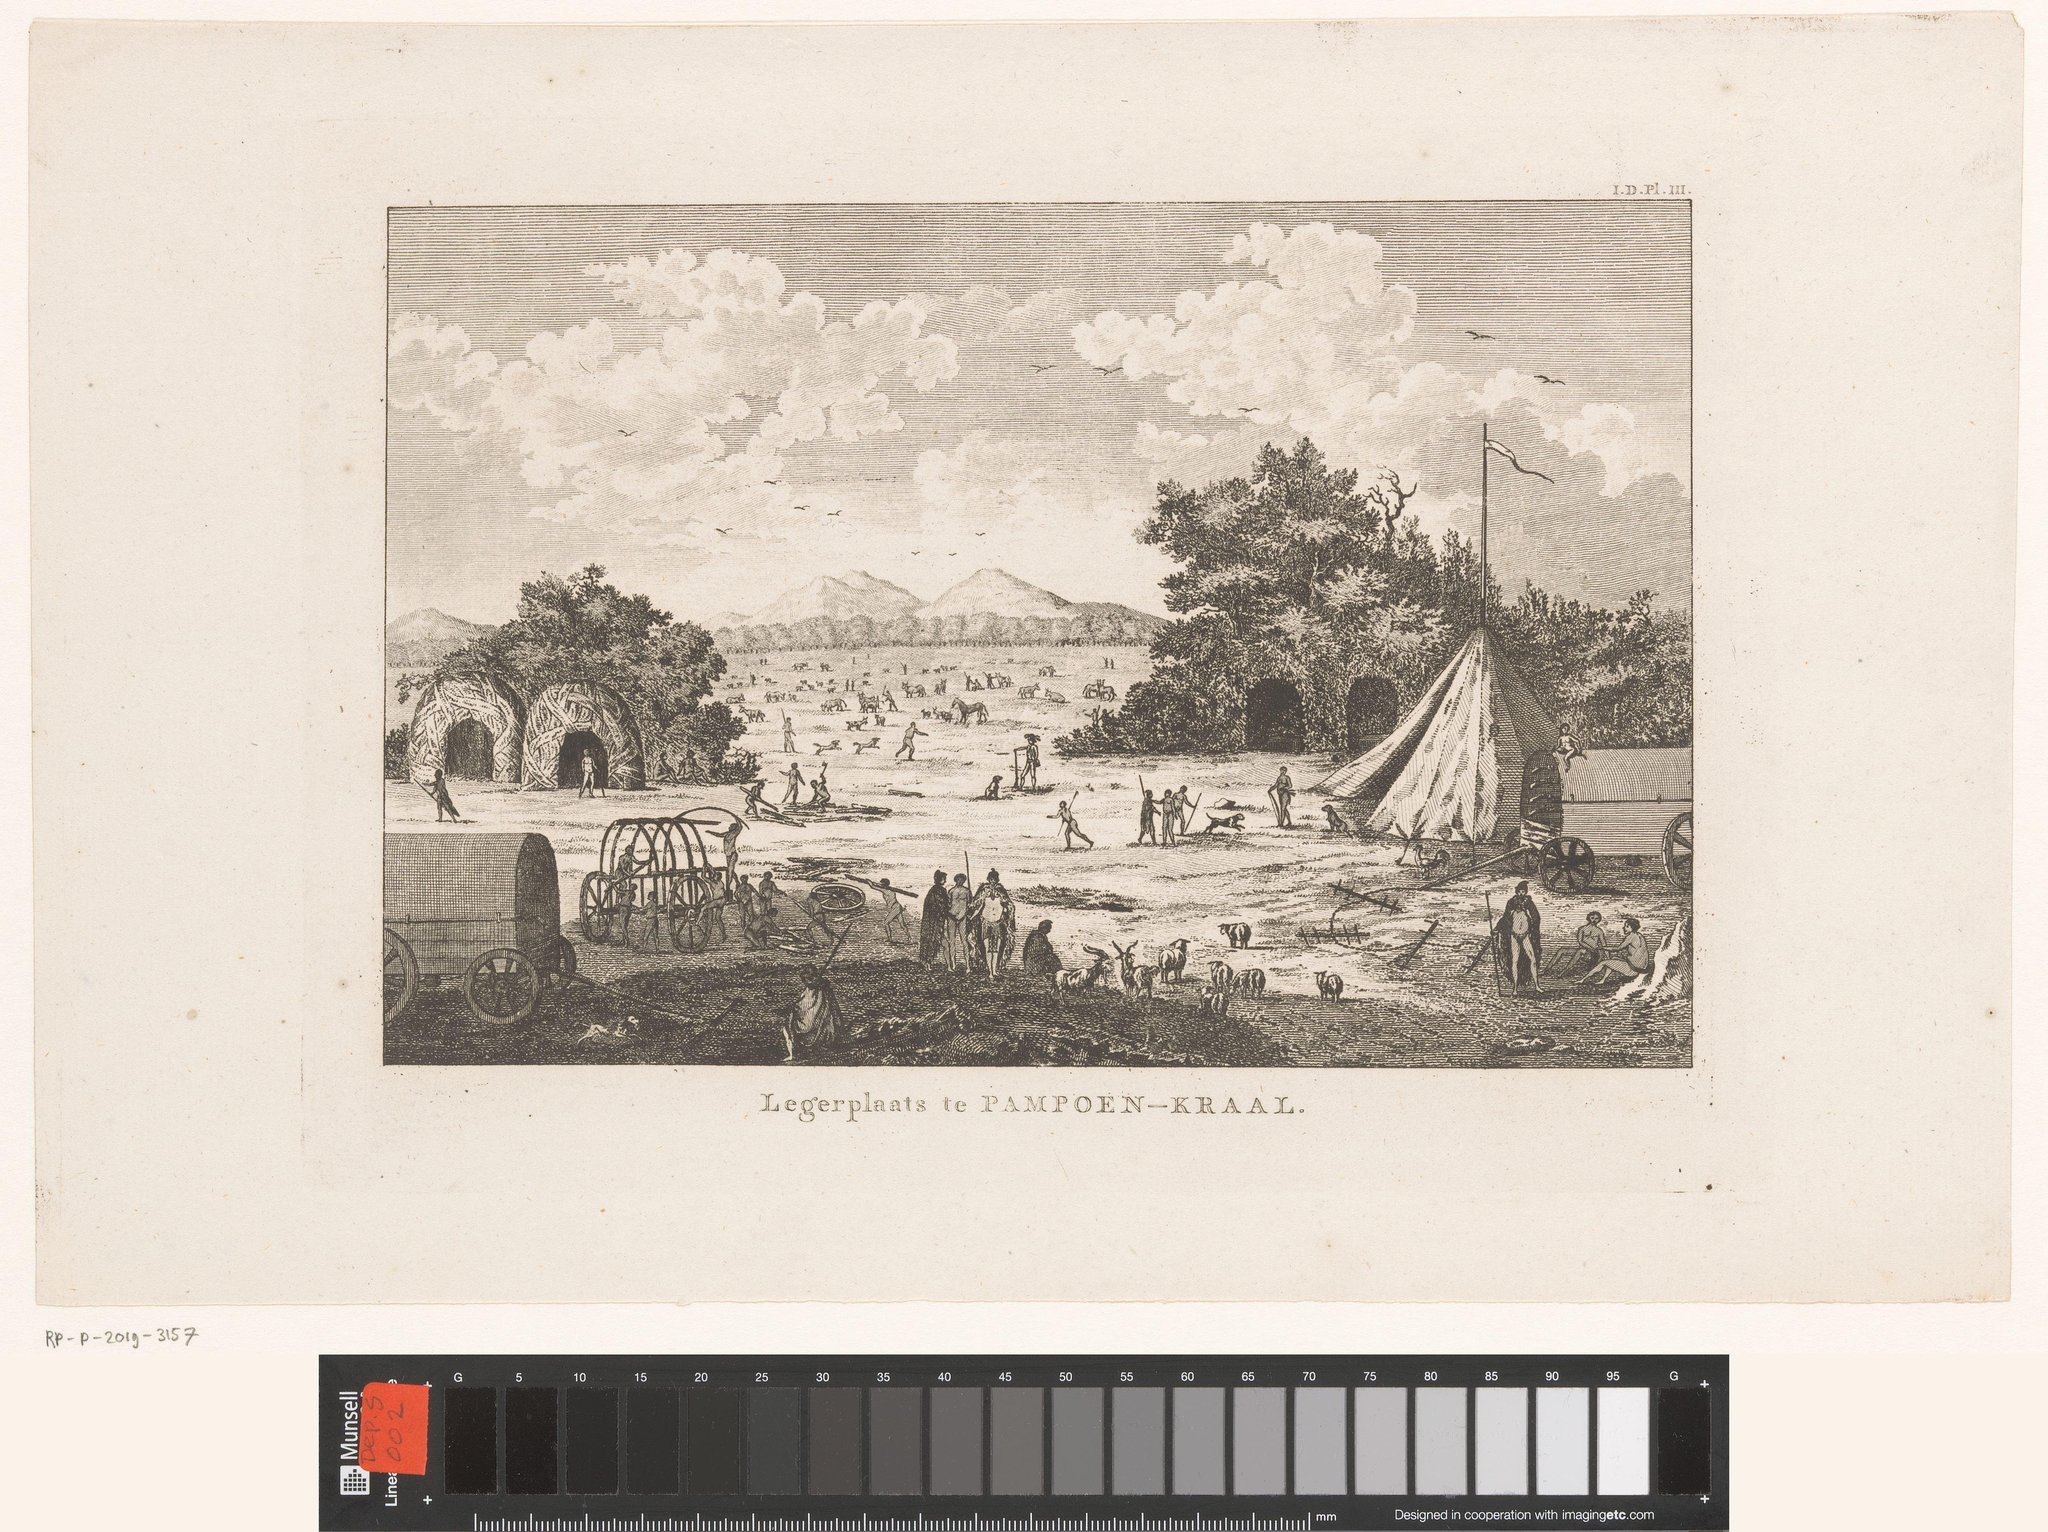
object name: book illustration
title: Oorspronkelijke bewoners van Durbanville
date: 1791-1798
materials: paper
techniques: etching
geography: amsterdam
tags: africans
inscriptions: watermark, collector's mark: Lugt 2228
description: Prent gebruikt voor: Le Vaillant, François. Reize in de binnenlanden van Afrika, langs de Kaap de Goede Hoop in de jaaren MDCCLXXX tot MDCCLXXXV gedaan door den Heer Le Vaillant. Leiden: Jan Honkoop en Abraham (II) Honkoop; Amsterdam: Johannes Allart, 1791-1798, dl. 1, p. 174 (verso).